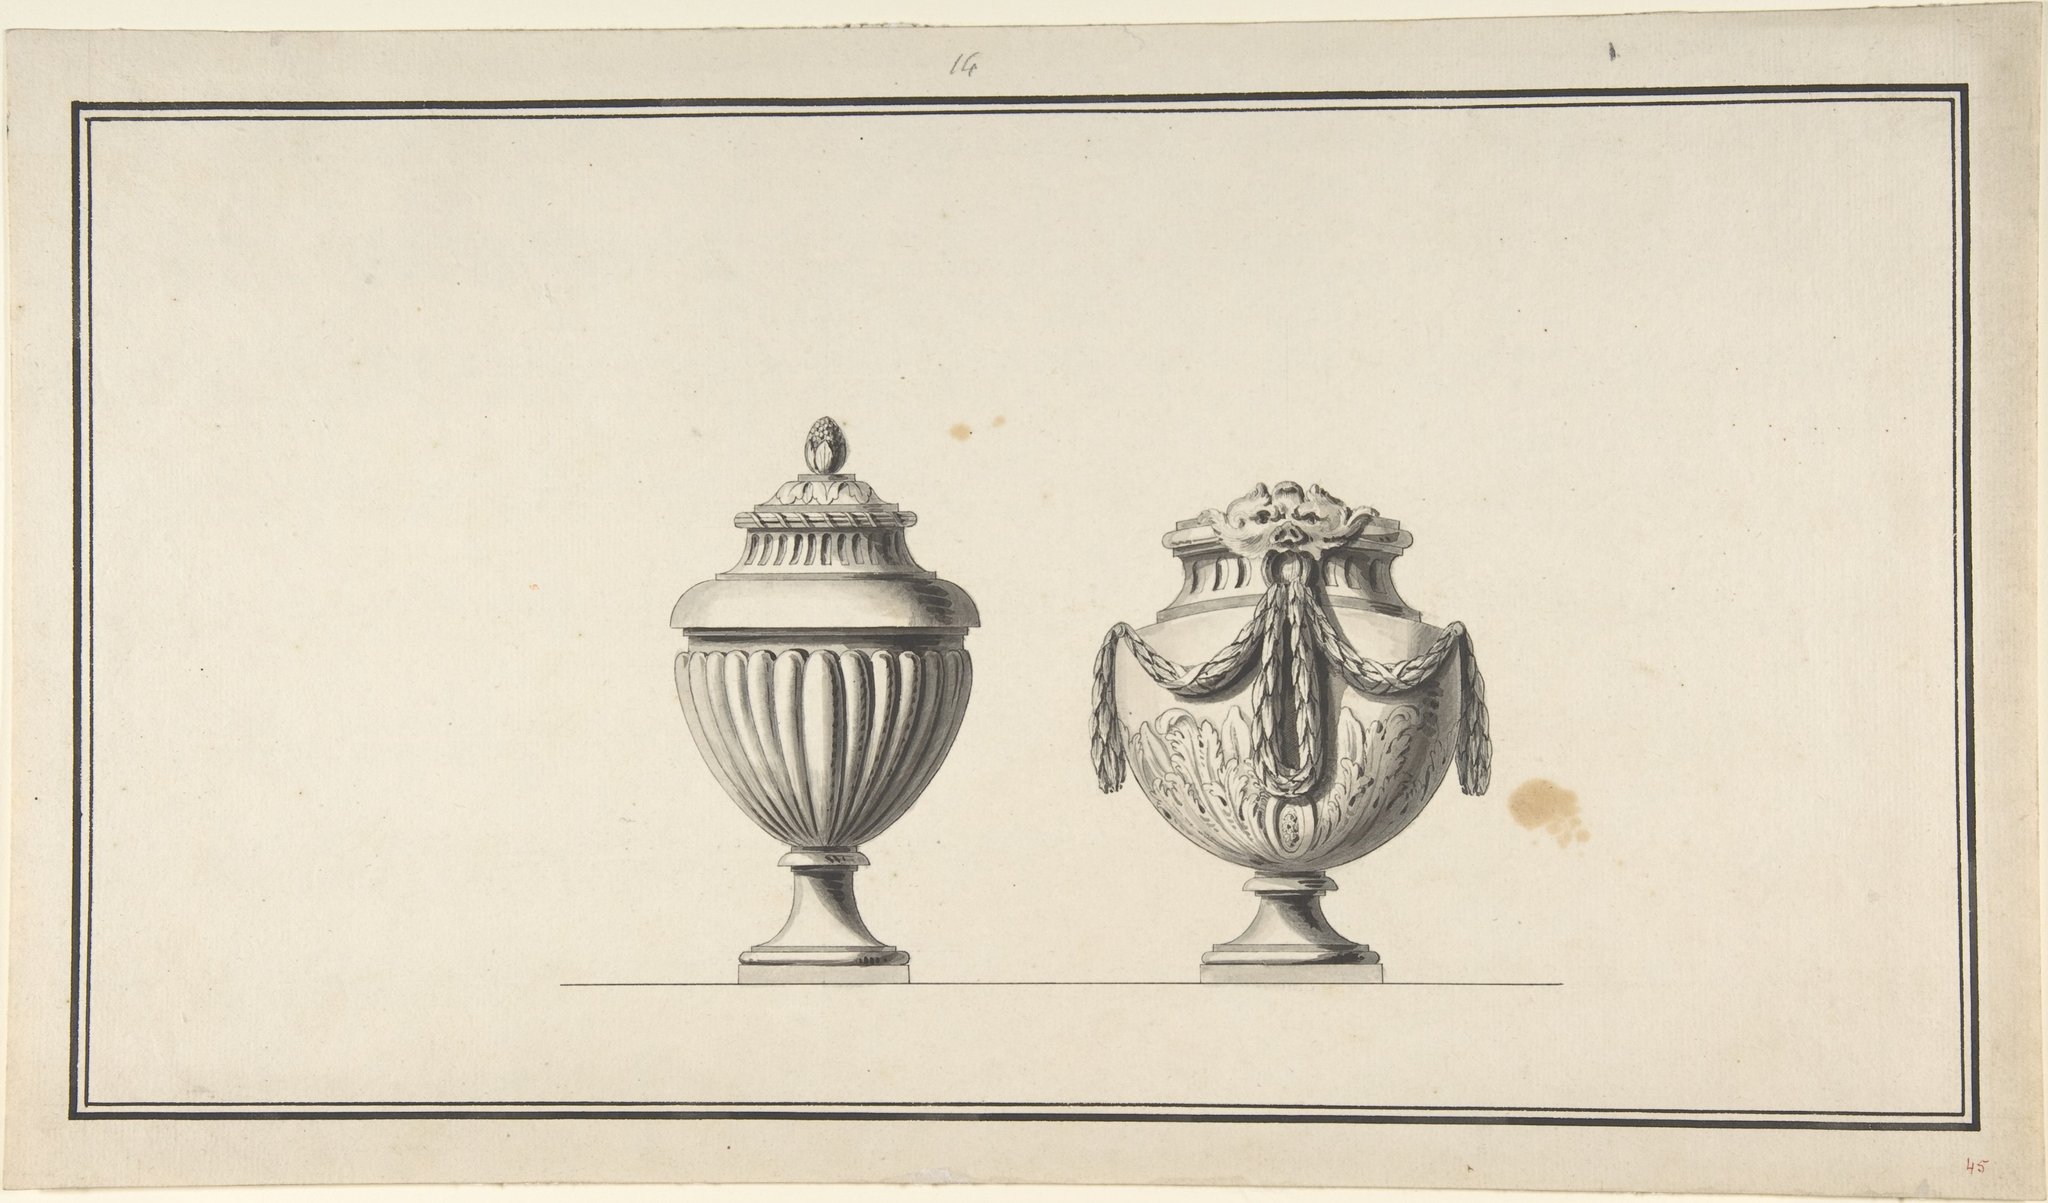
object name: drawing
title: Design for Urn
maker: anonymous, french, 18th century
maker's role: artist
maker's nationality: french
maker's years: 1700-1800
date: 1770-1790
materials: ink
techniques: brush, pen, wash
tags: urns